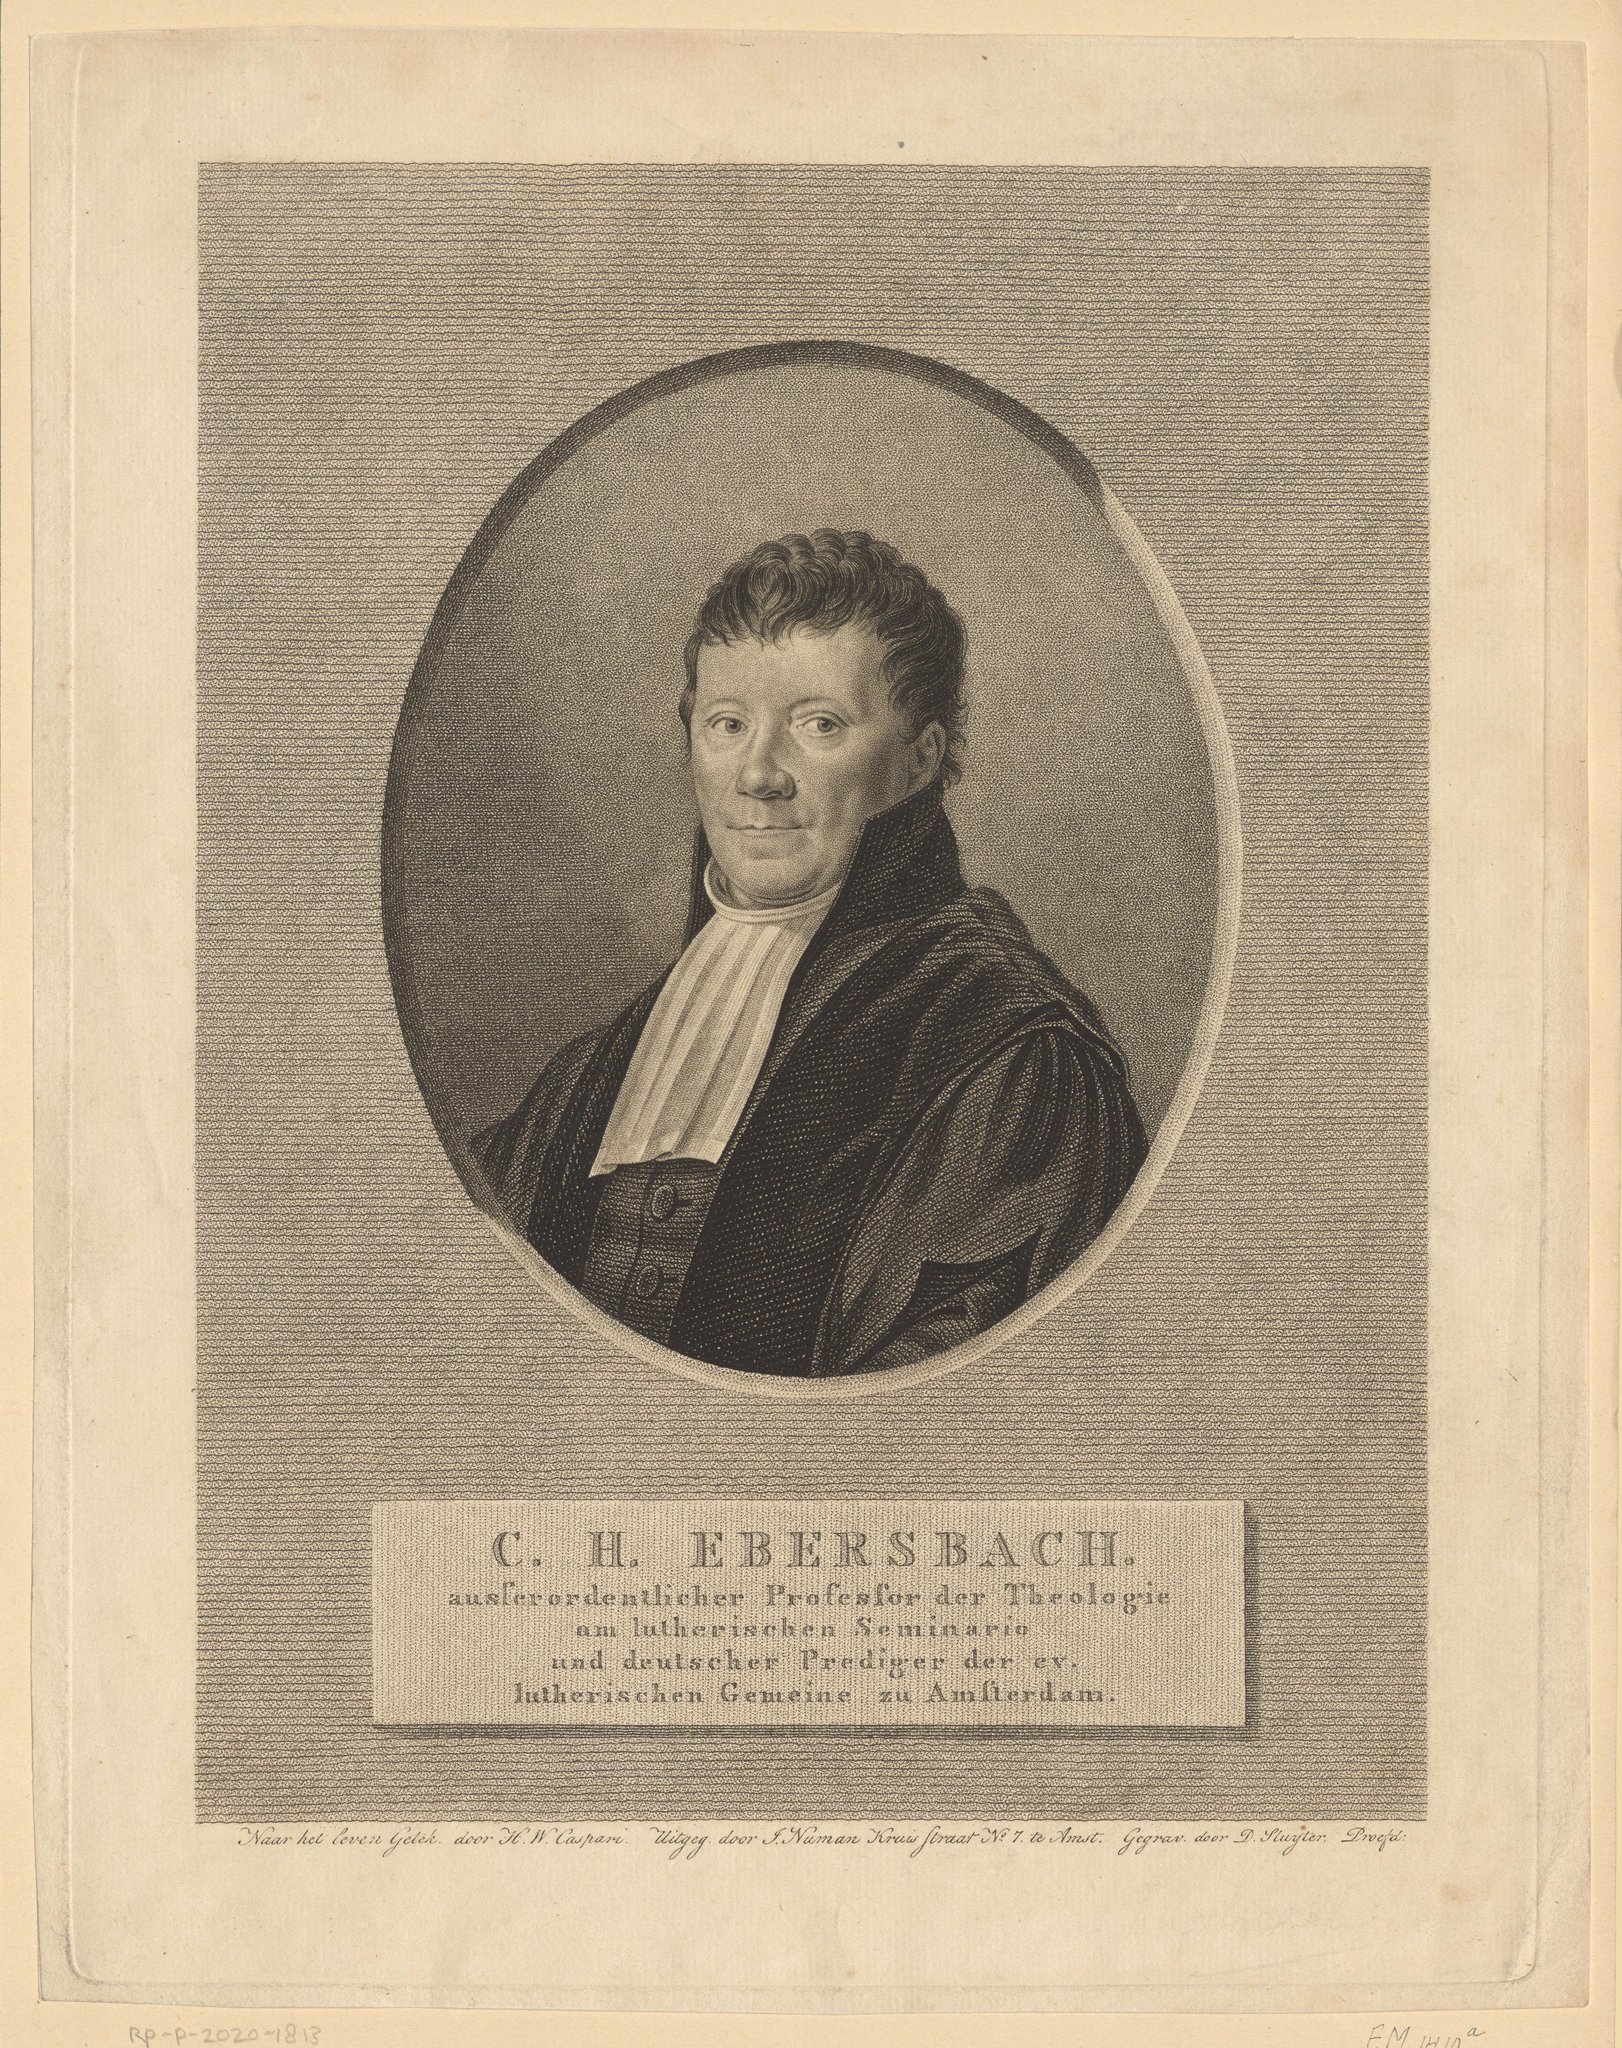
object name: print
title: Portret van Christiaan Henrich Ebersbach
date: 1818-1823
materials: paper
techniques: etching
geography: amsterdam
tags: historical persons